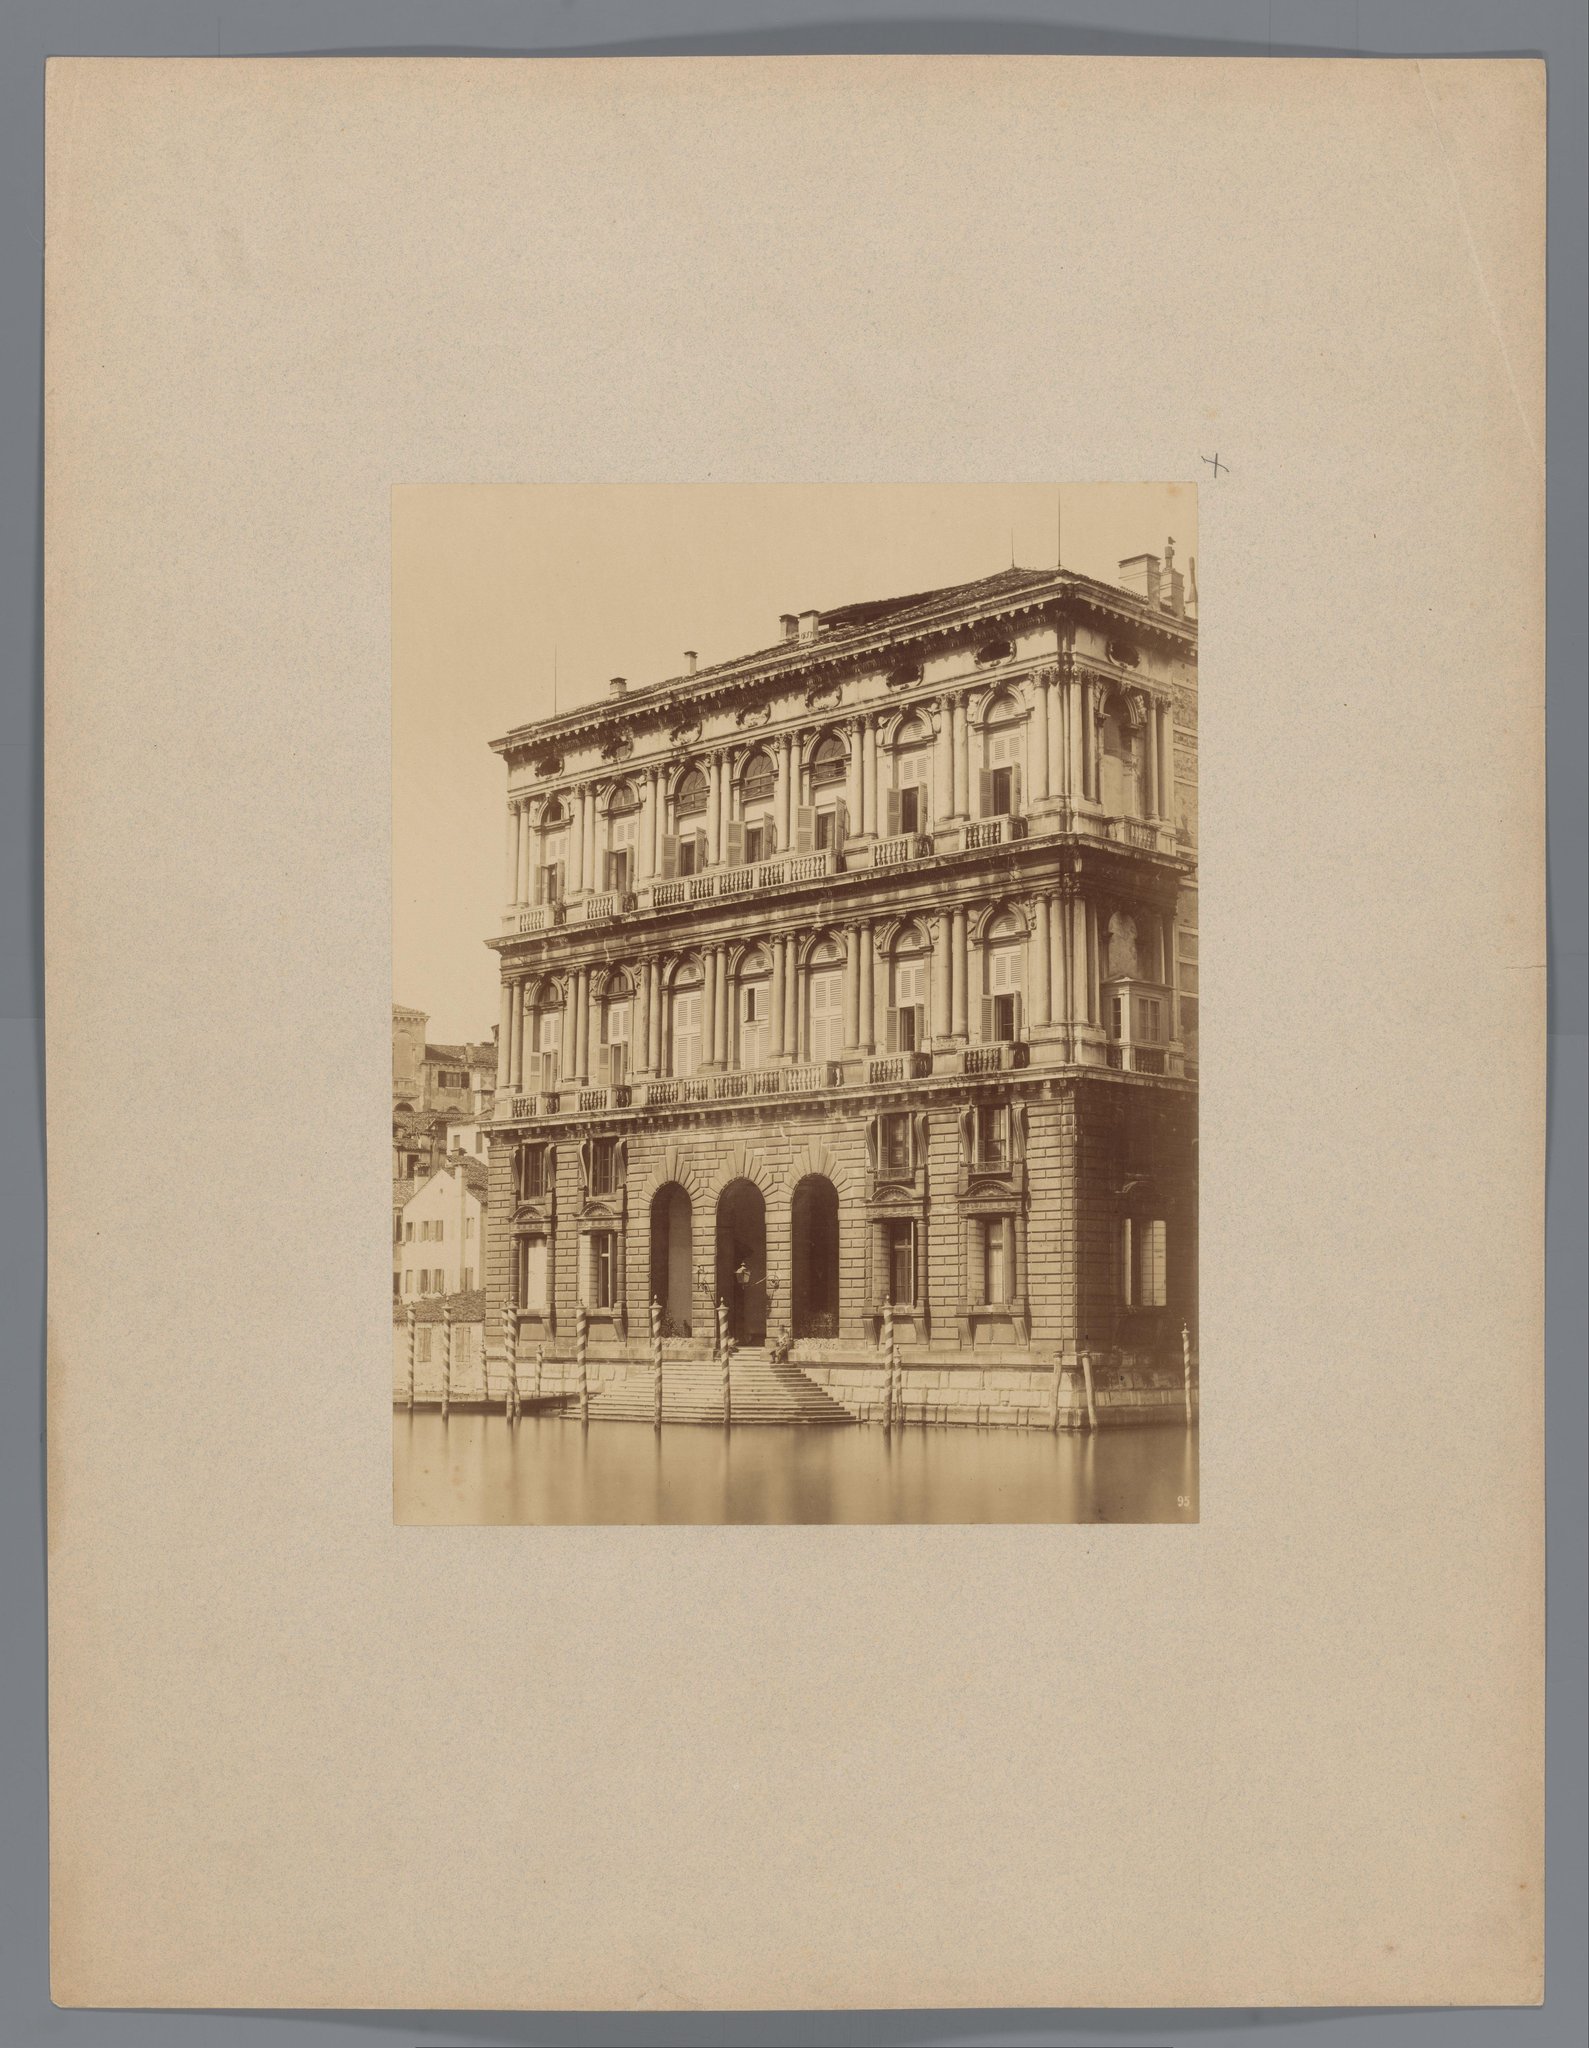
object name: photograph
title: Palazzo Corner della Ca' te Venetië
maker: carlo naya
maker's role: fotograaf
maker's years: 1816-1882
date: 1880-1900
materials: cardboard, paper, photographic support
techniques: albumen print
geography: venice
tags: venice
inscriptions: : ‘95’